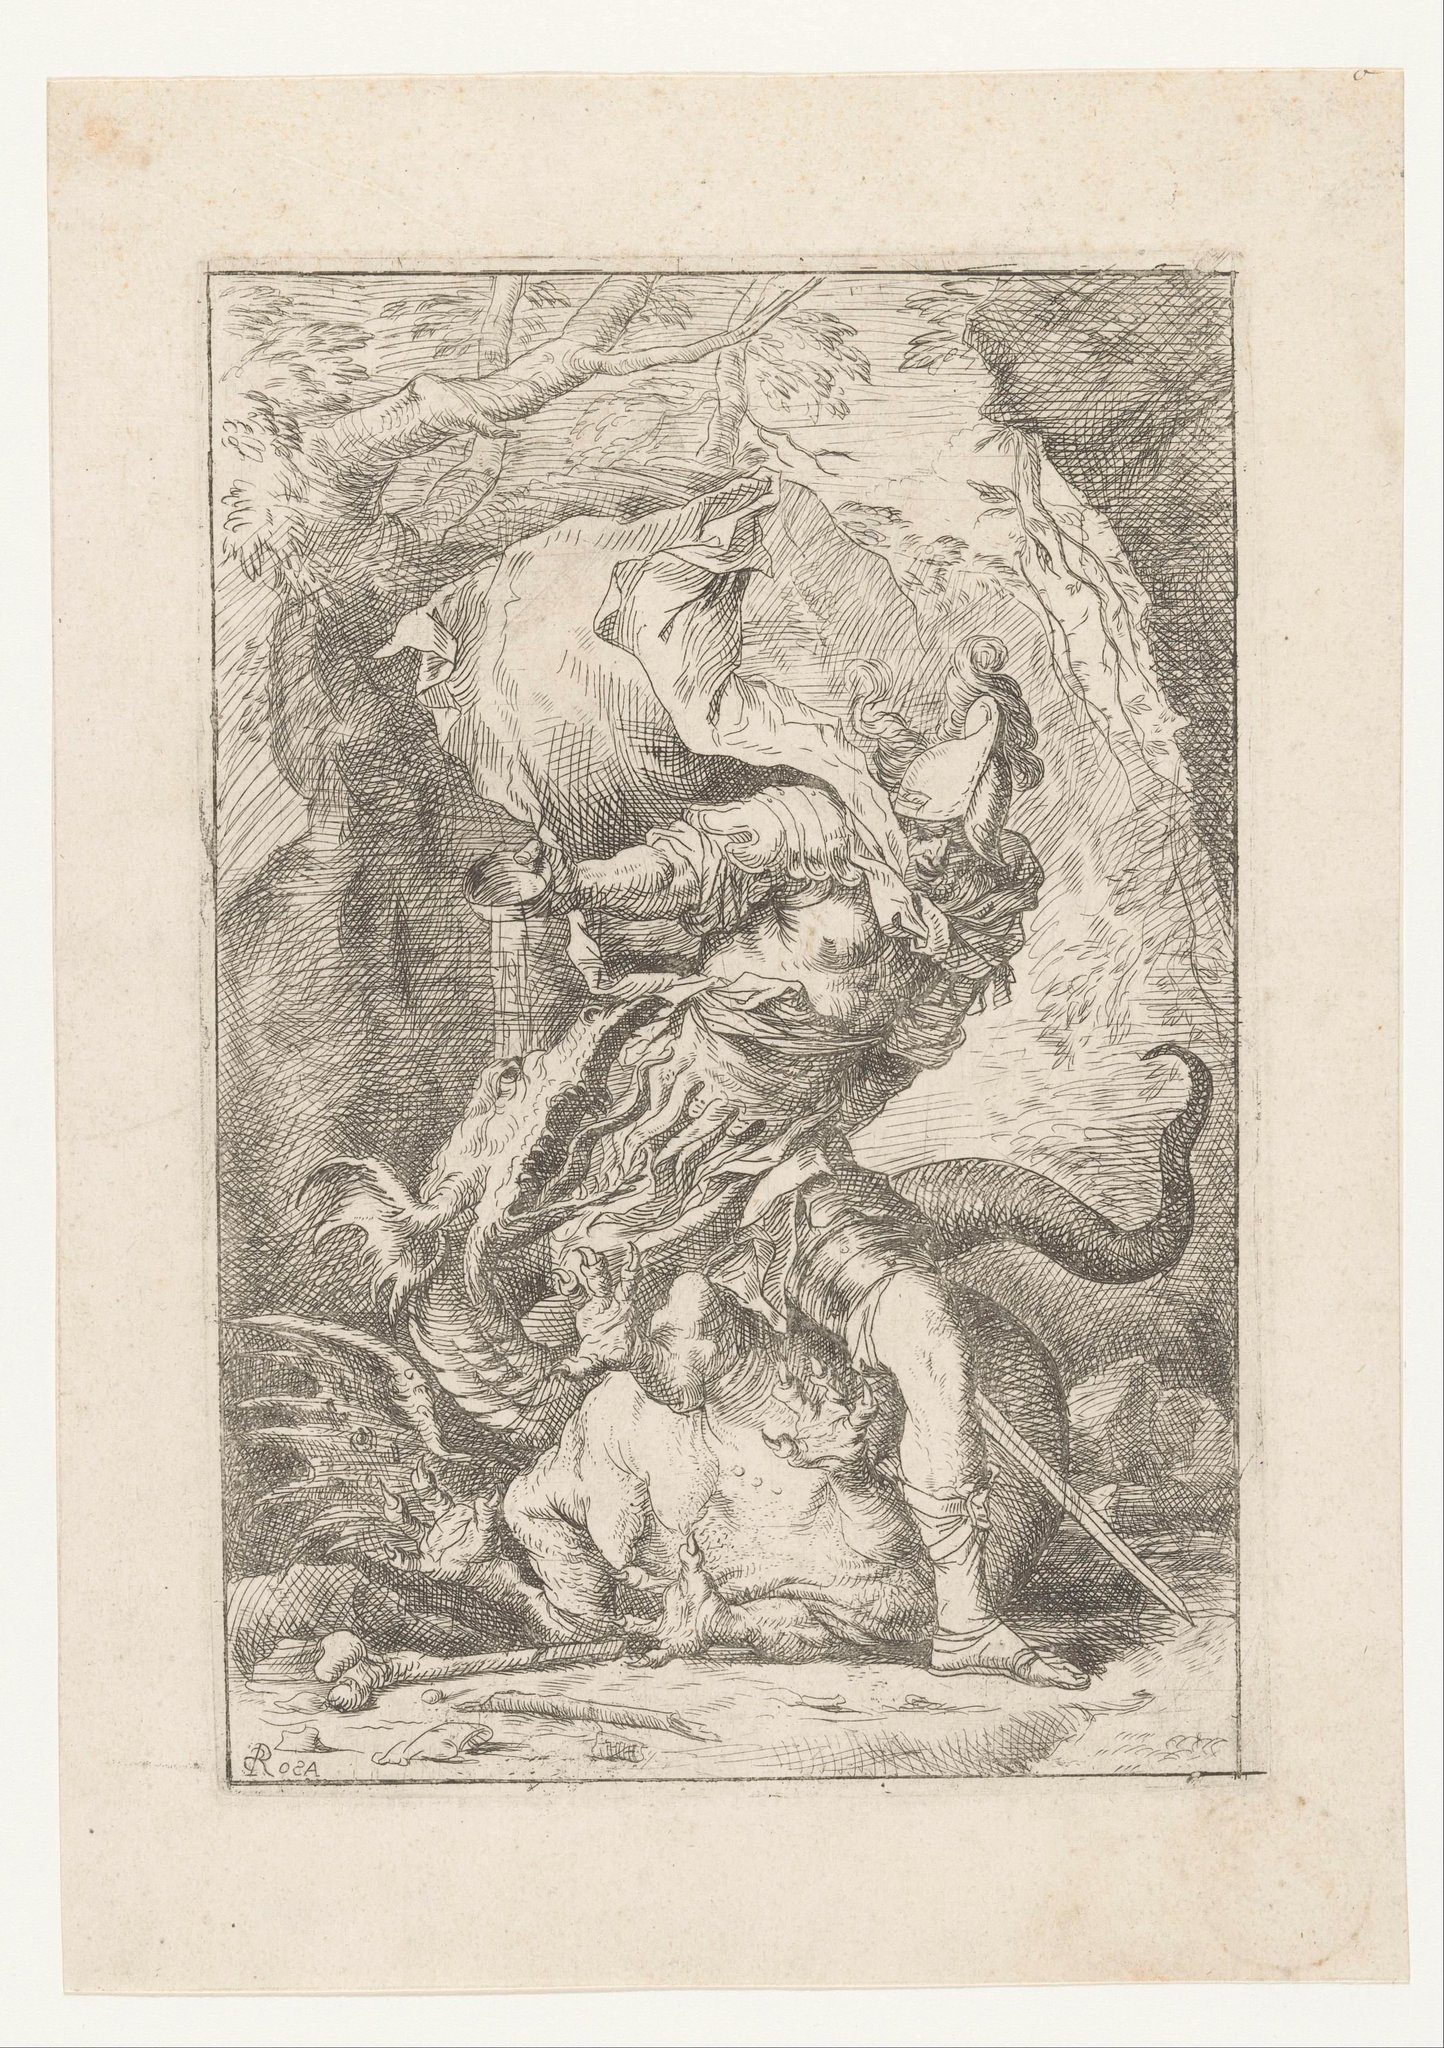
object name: print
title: Jason en de draak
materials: paper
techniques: engraving, etching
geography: italy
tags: fight with the dragon; jason sprinkles a drug in its eyes, possibly assisted by medea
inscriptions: collector's mark: Lugt 240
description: Spiegelbeeldige kopie naar een prent door Salvator Rosa, naar een tekening in het Nationalmuseum te Stockholm.